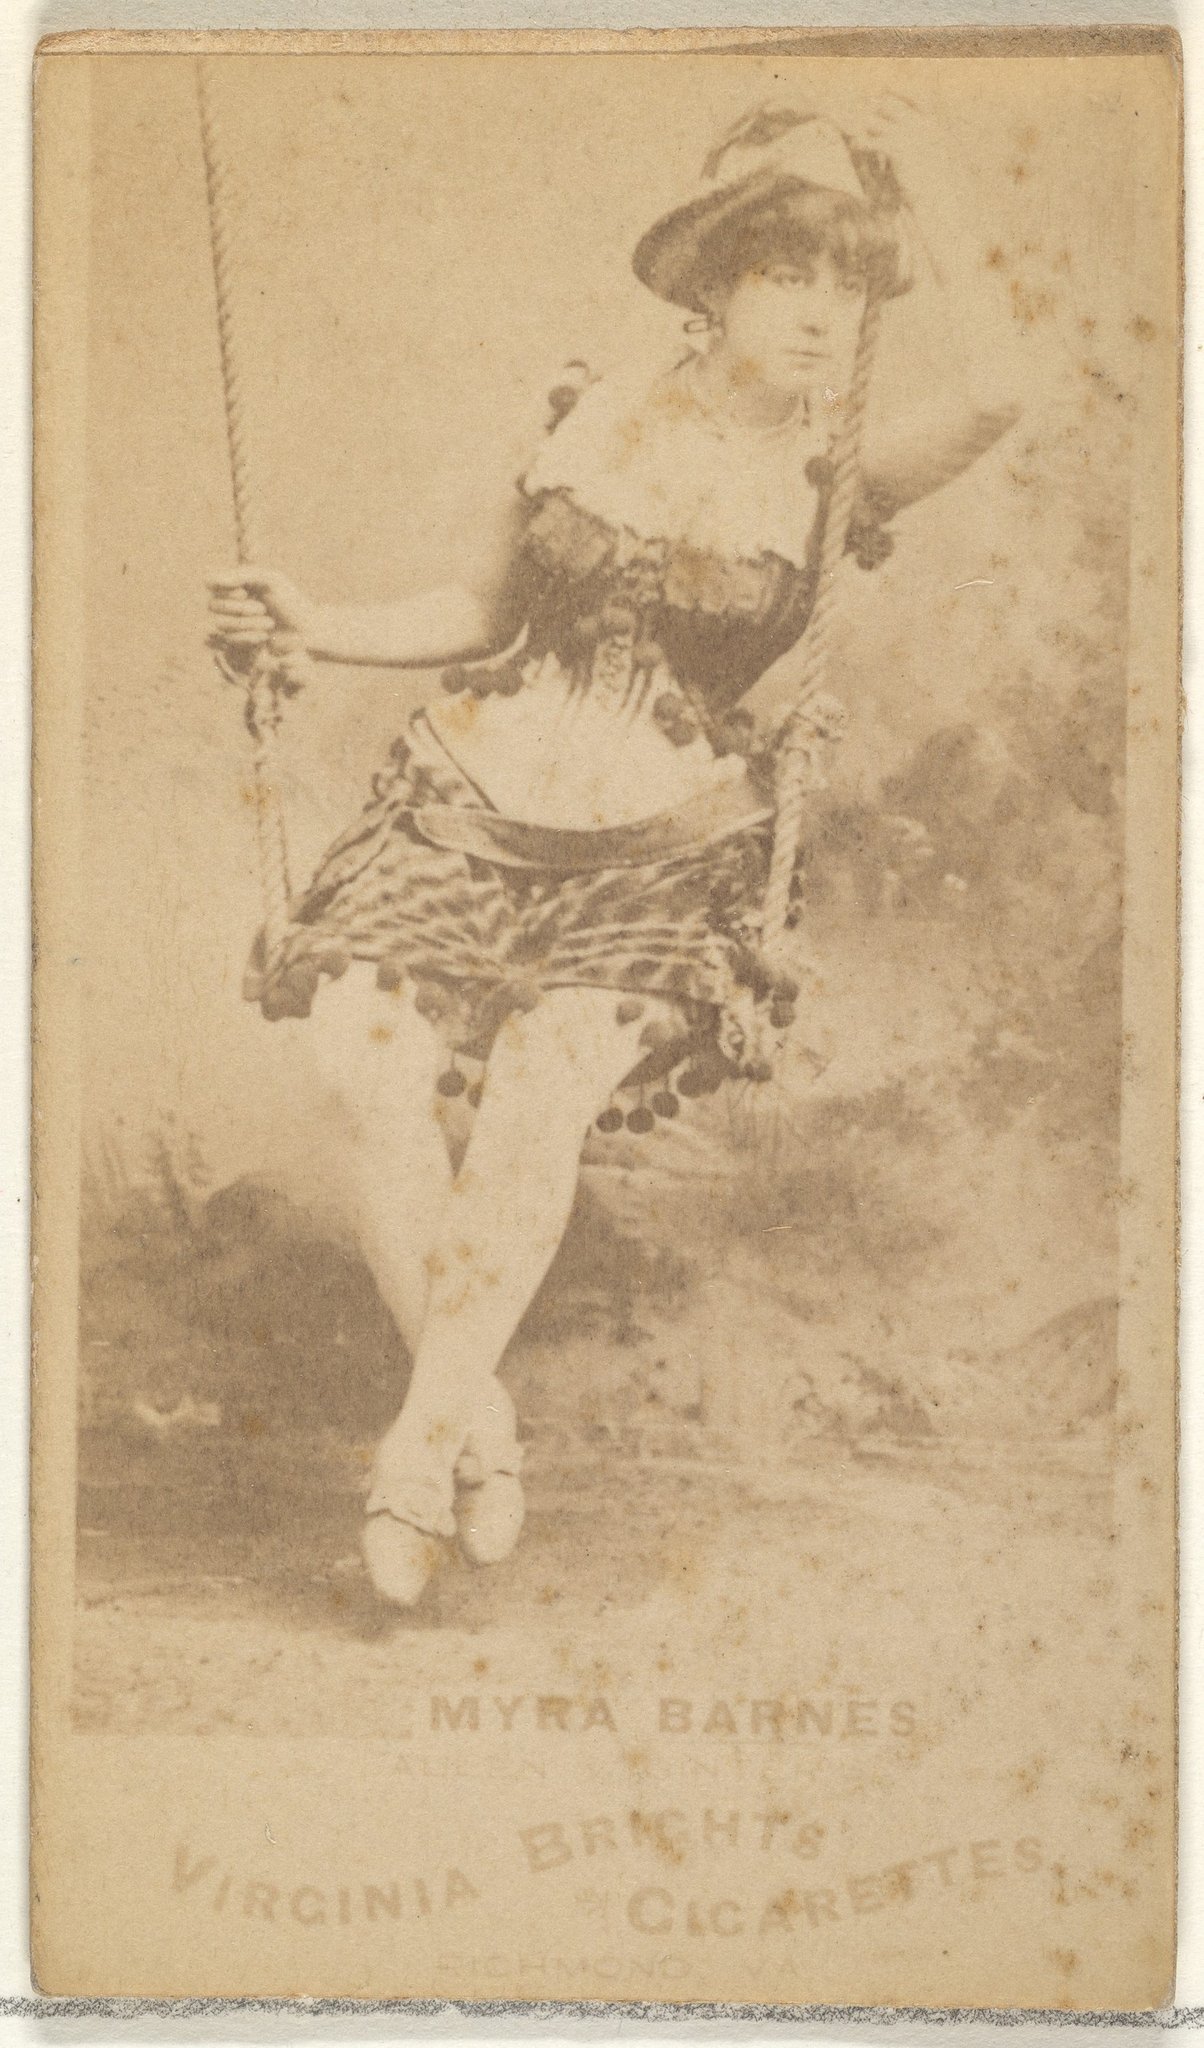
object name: photograph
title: Myra Barnes, from the Actors and Actresses series (N45, Type 1) for Virginia Brights Cigarettes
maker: allen & ginter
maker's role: publisher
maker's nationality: american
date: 1888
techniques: albumen silver print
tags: portraits,women,actresses